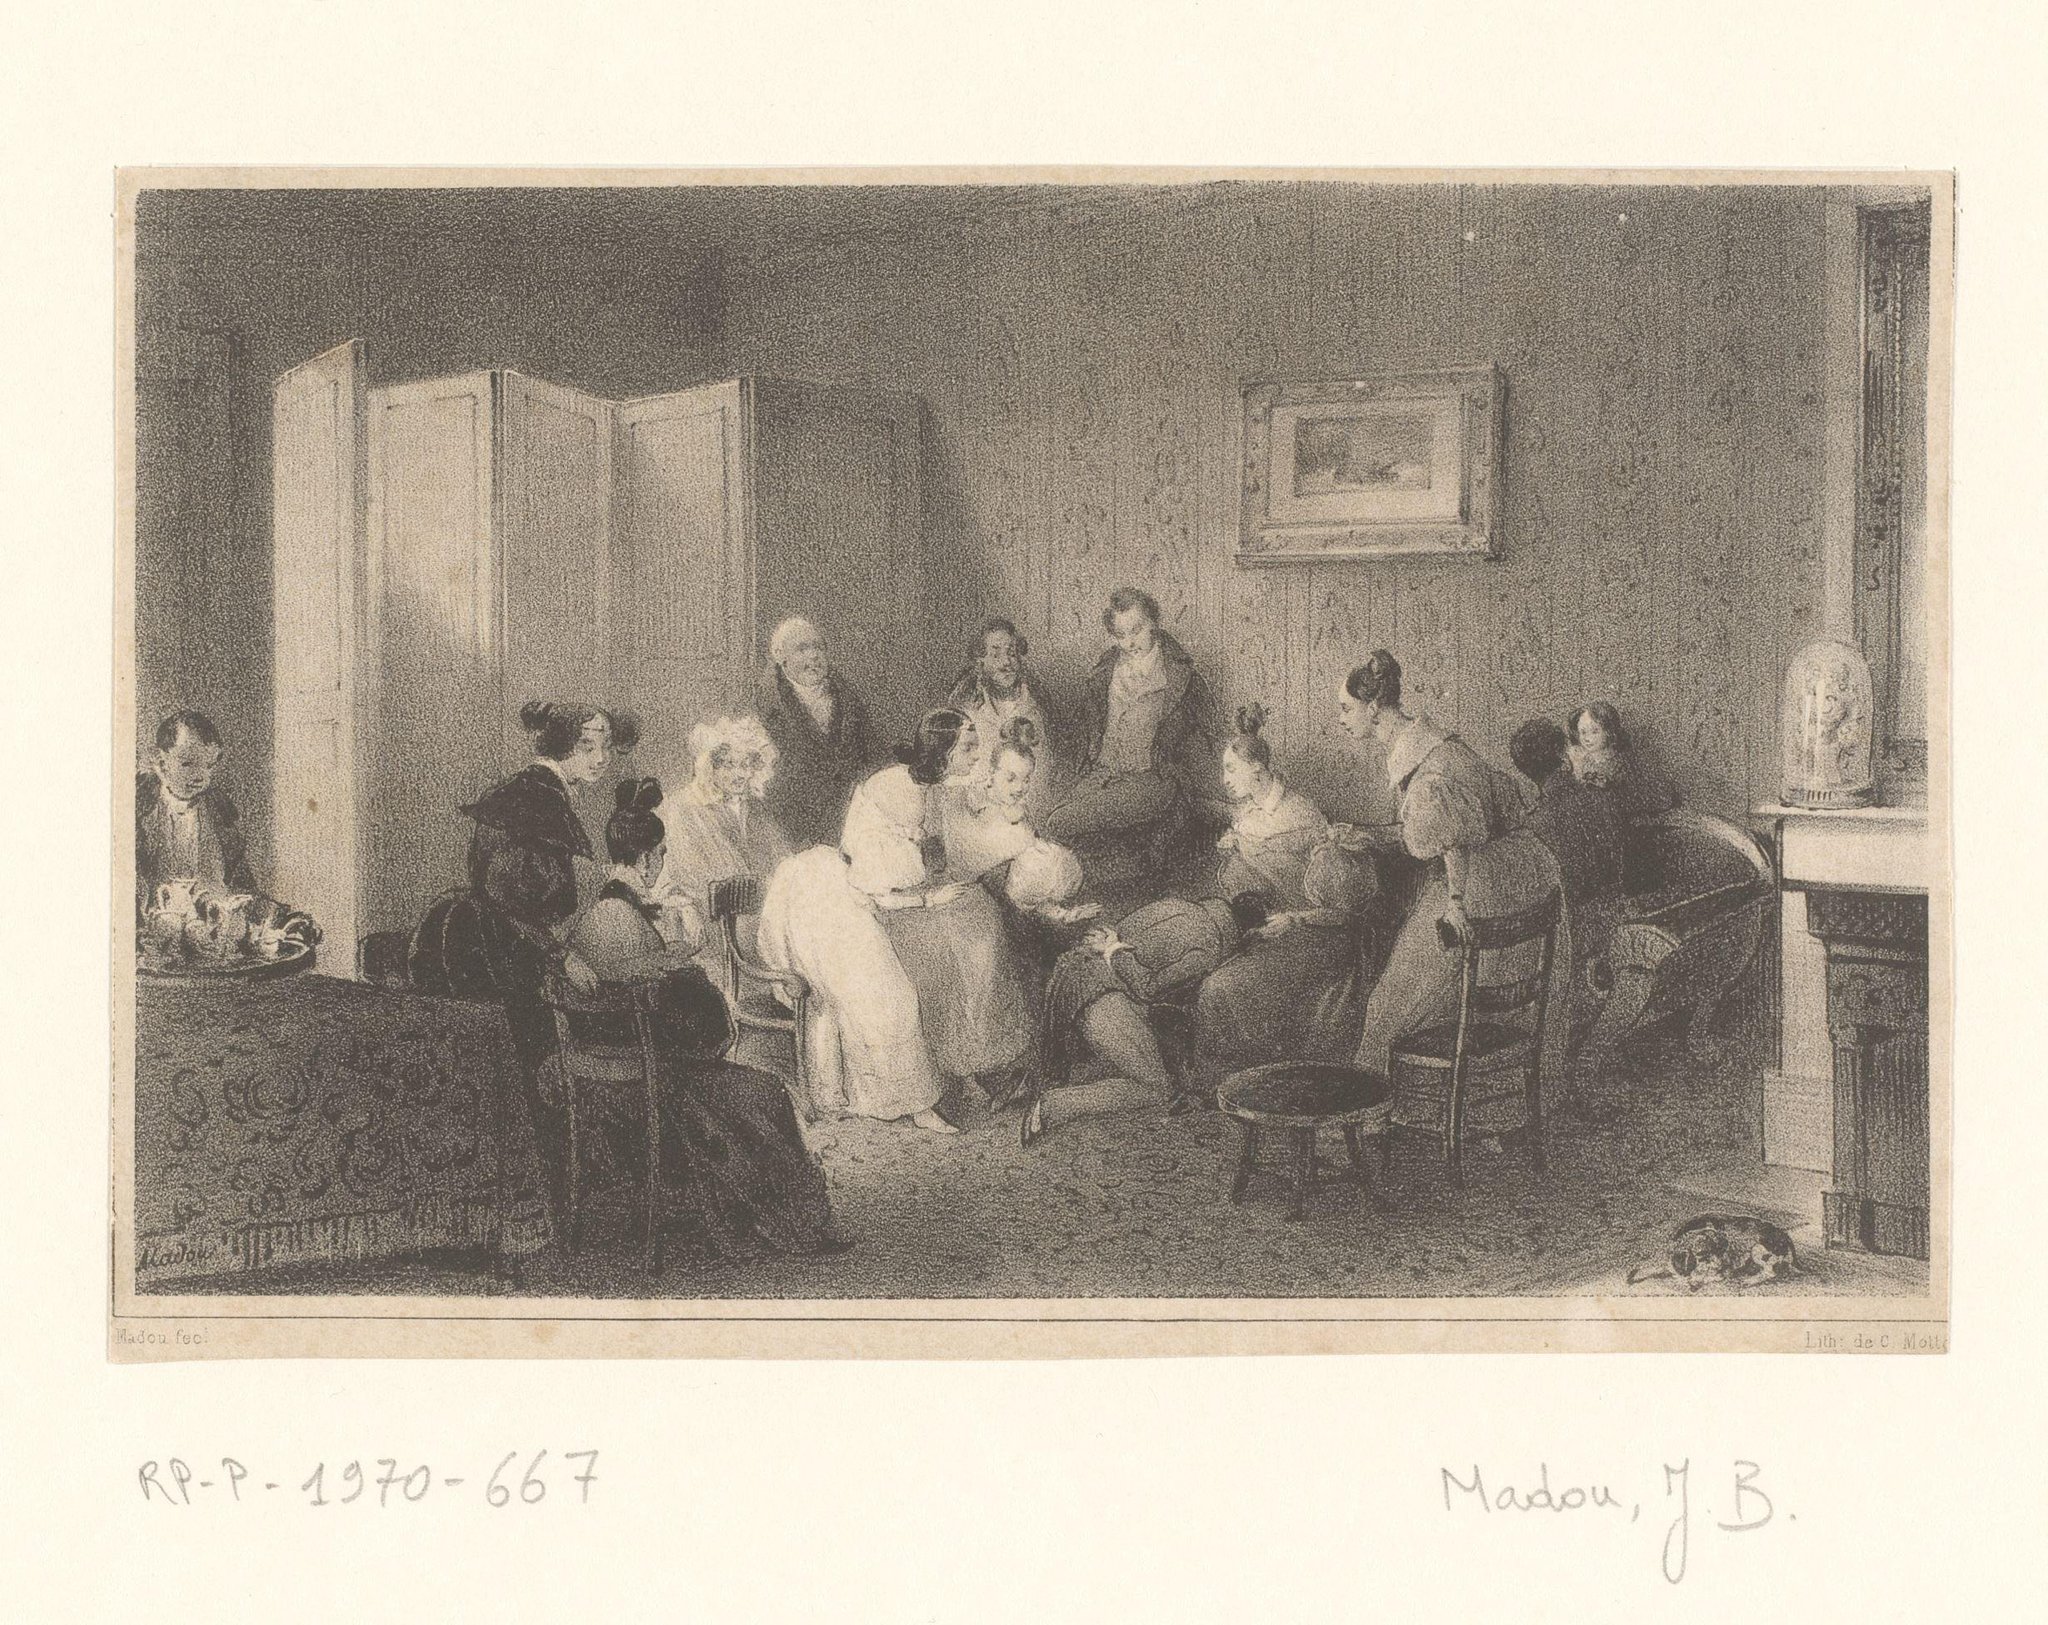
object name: print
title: La main chaude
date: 1833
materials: paper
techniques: lithograph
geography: paris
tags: games without play material, visiting; receiving guests; elegant company, interior of the house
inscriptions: collector's mark: Lugt 2228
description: Het spel dat wordt gespeeld, wordt ook wel 'warme hand' genoemd.